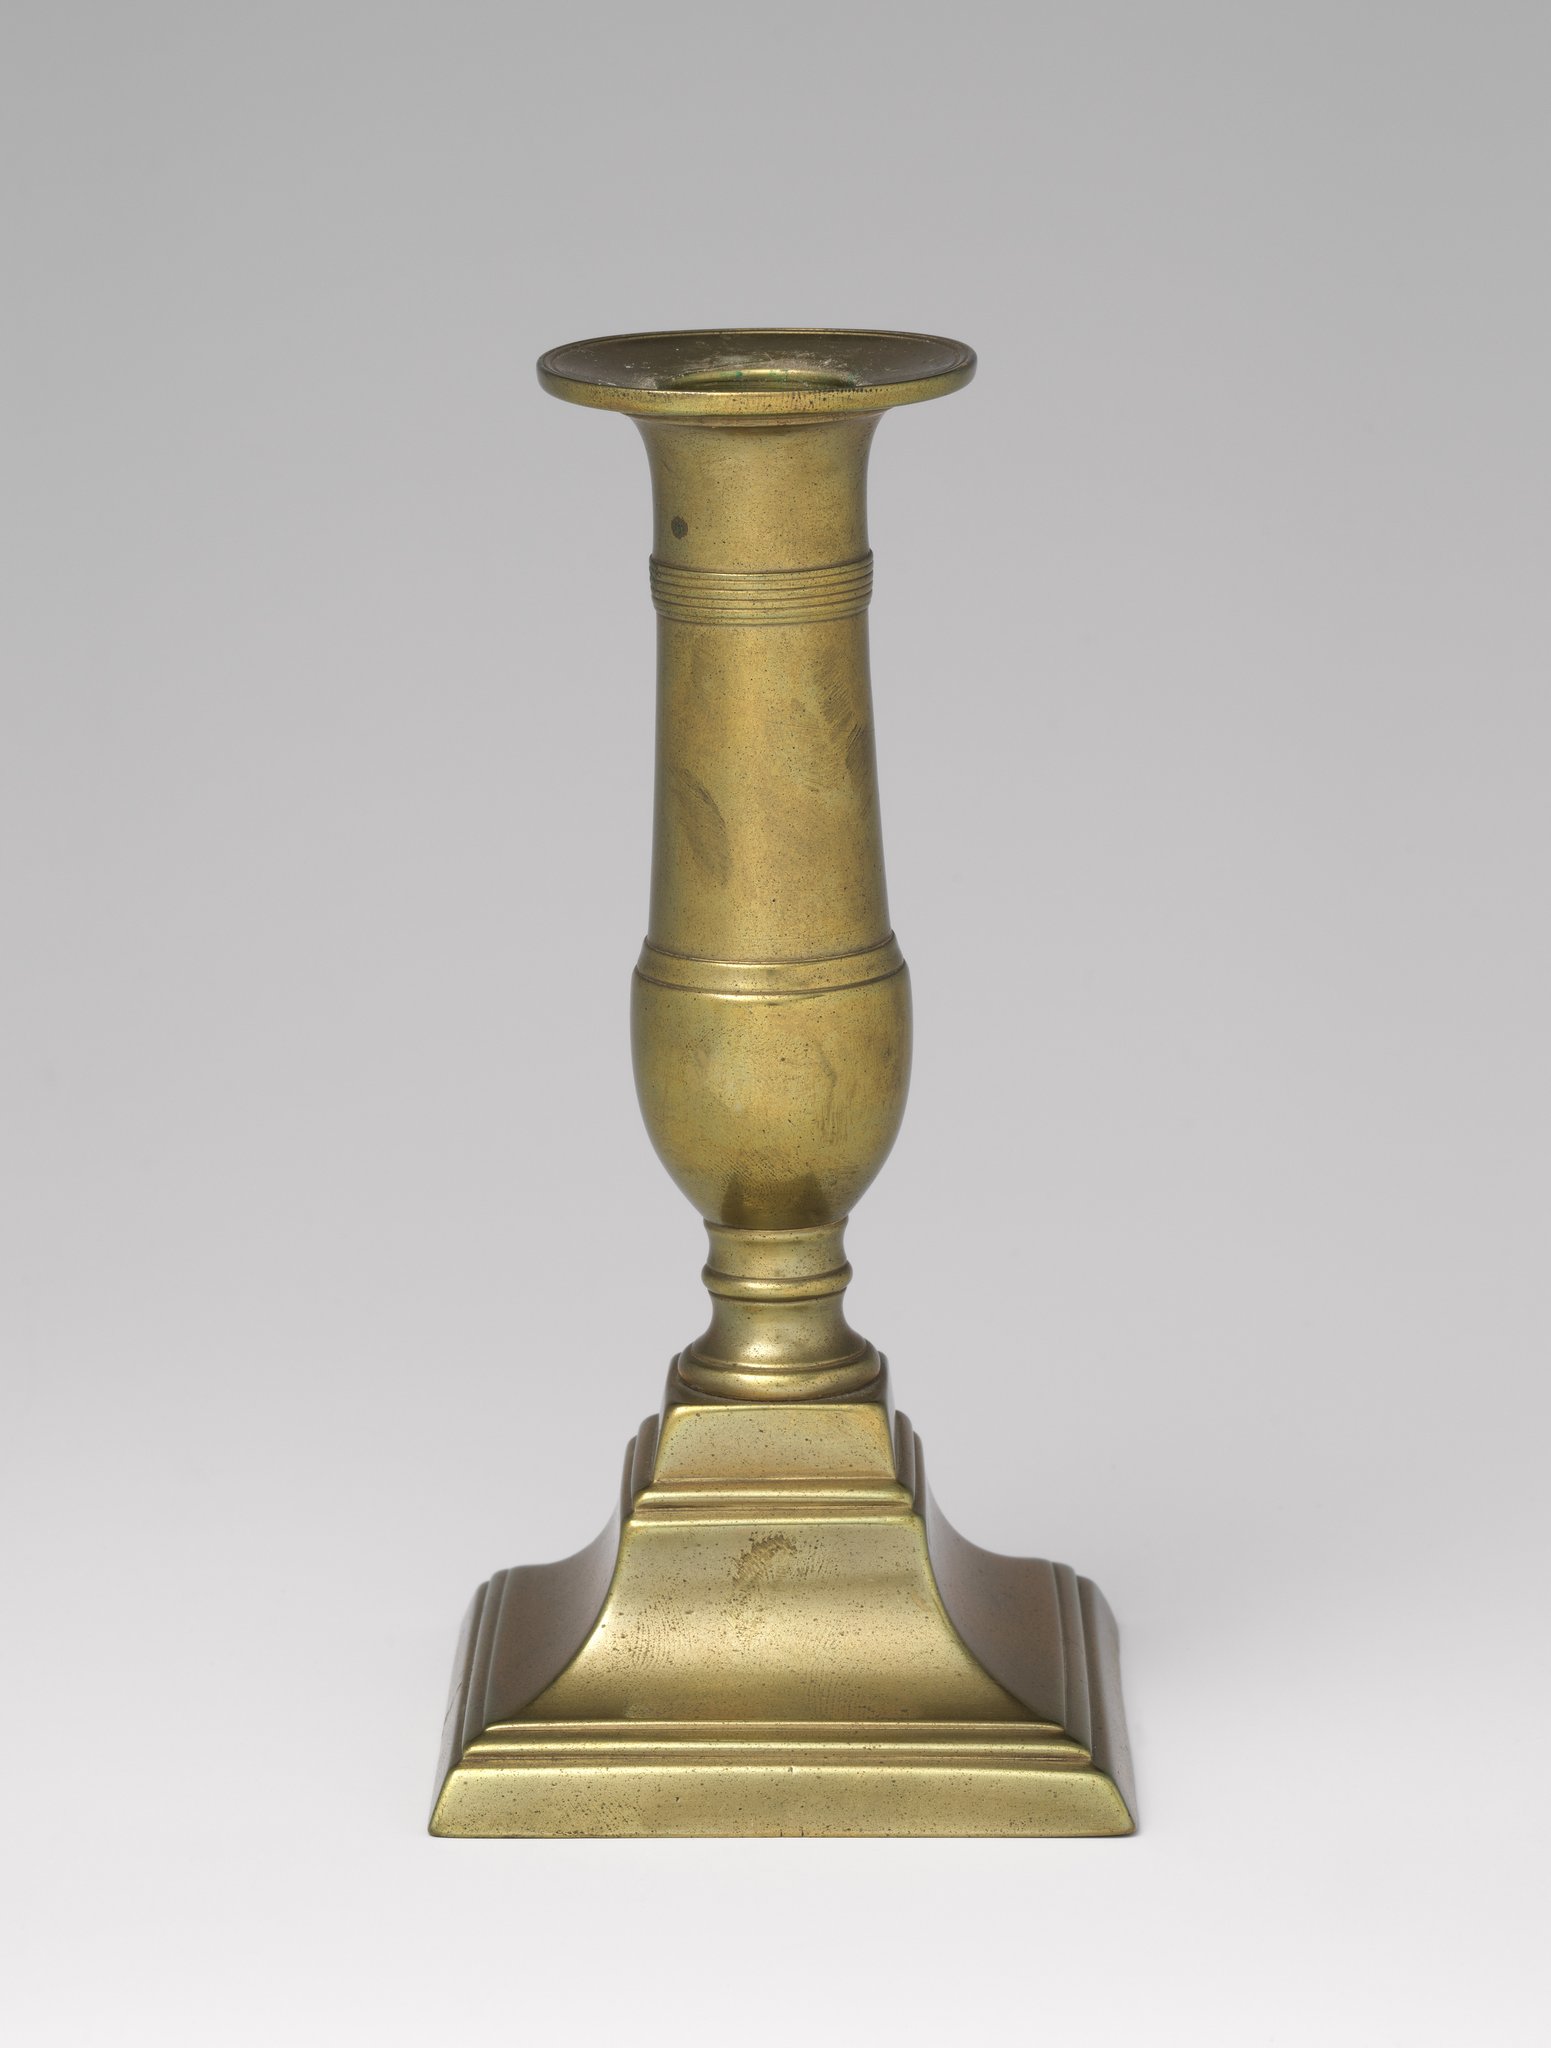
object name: candlestick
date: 1700-1800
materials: brass